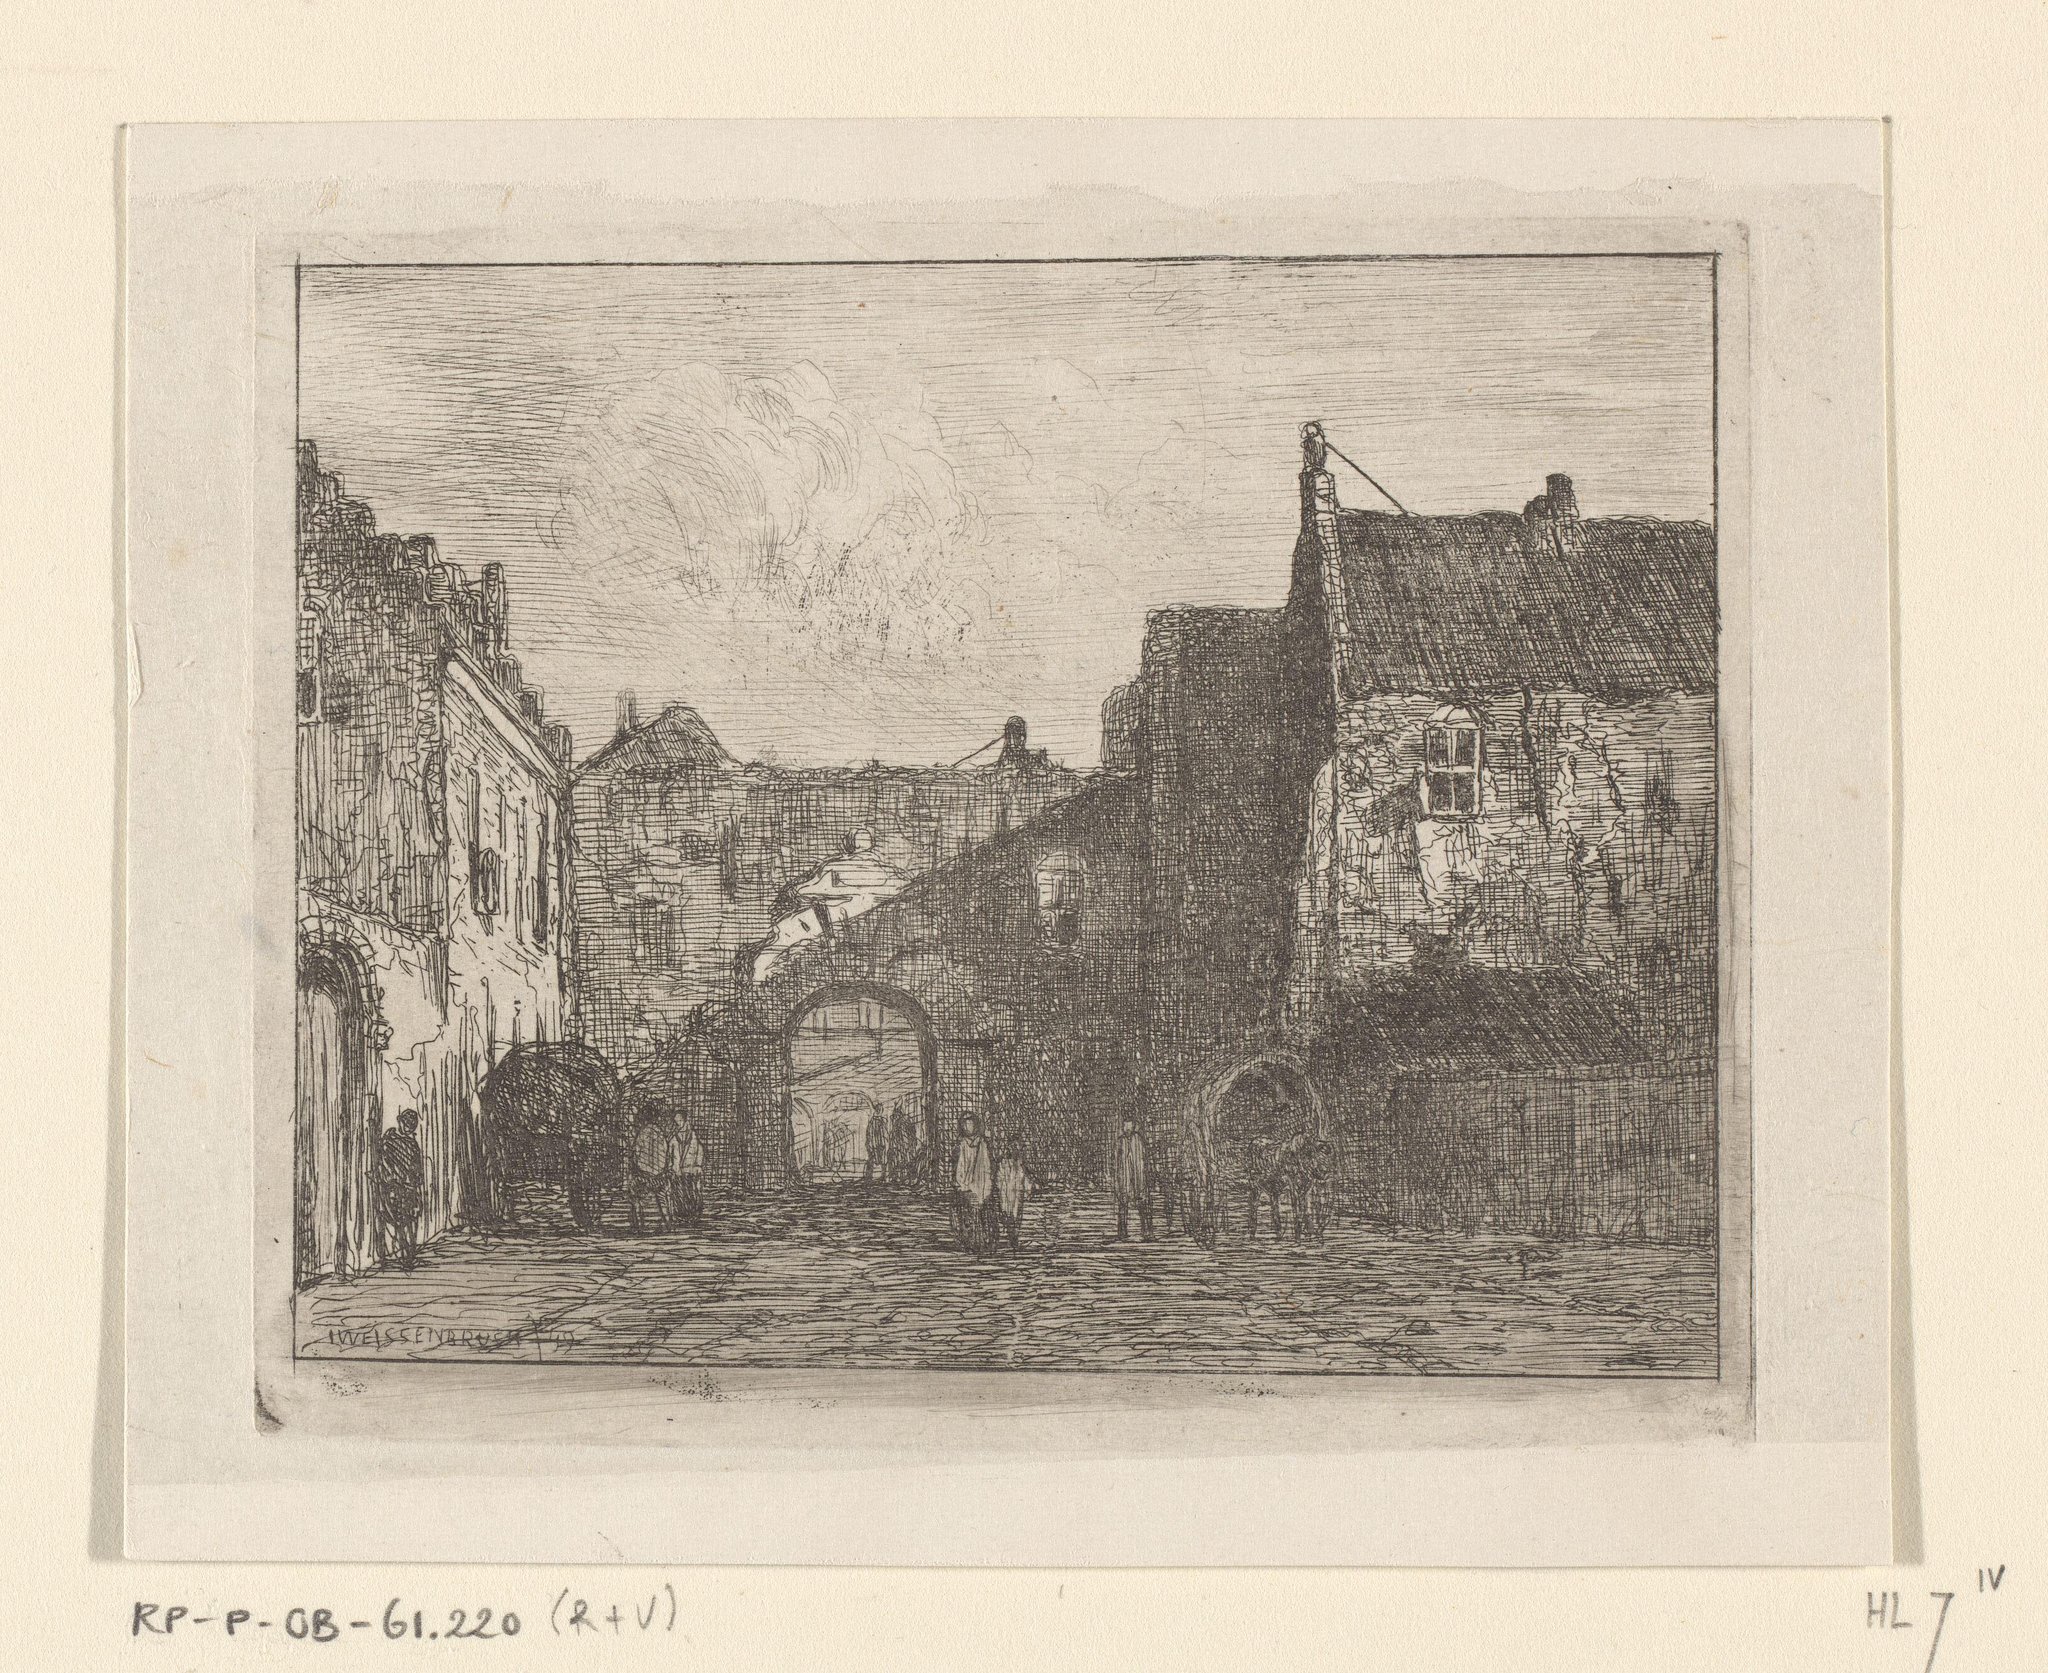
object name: print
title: Gezicht op het Binnenhof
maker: jan weissenbruch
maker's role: painter, print maker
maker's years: 1822-1880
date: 1849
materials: paper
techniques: etching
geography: the hague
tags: city-view, and landscape with man-made constructions, gate, entrance, horse, passenger carriage, civic architecture; edifices; dwellings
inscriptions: date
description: Op het Binnenhof te Den Haag staan enkele figuren bij twee koetsen met paarden. In de verte ligt de Mauritspoort gezien door de Middenpoort met rechts een gedeelte van de Ridderzaal.